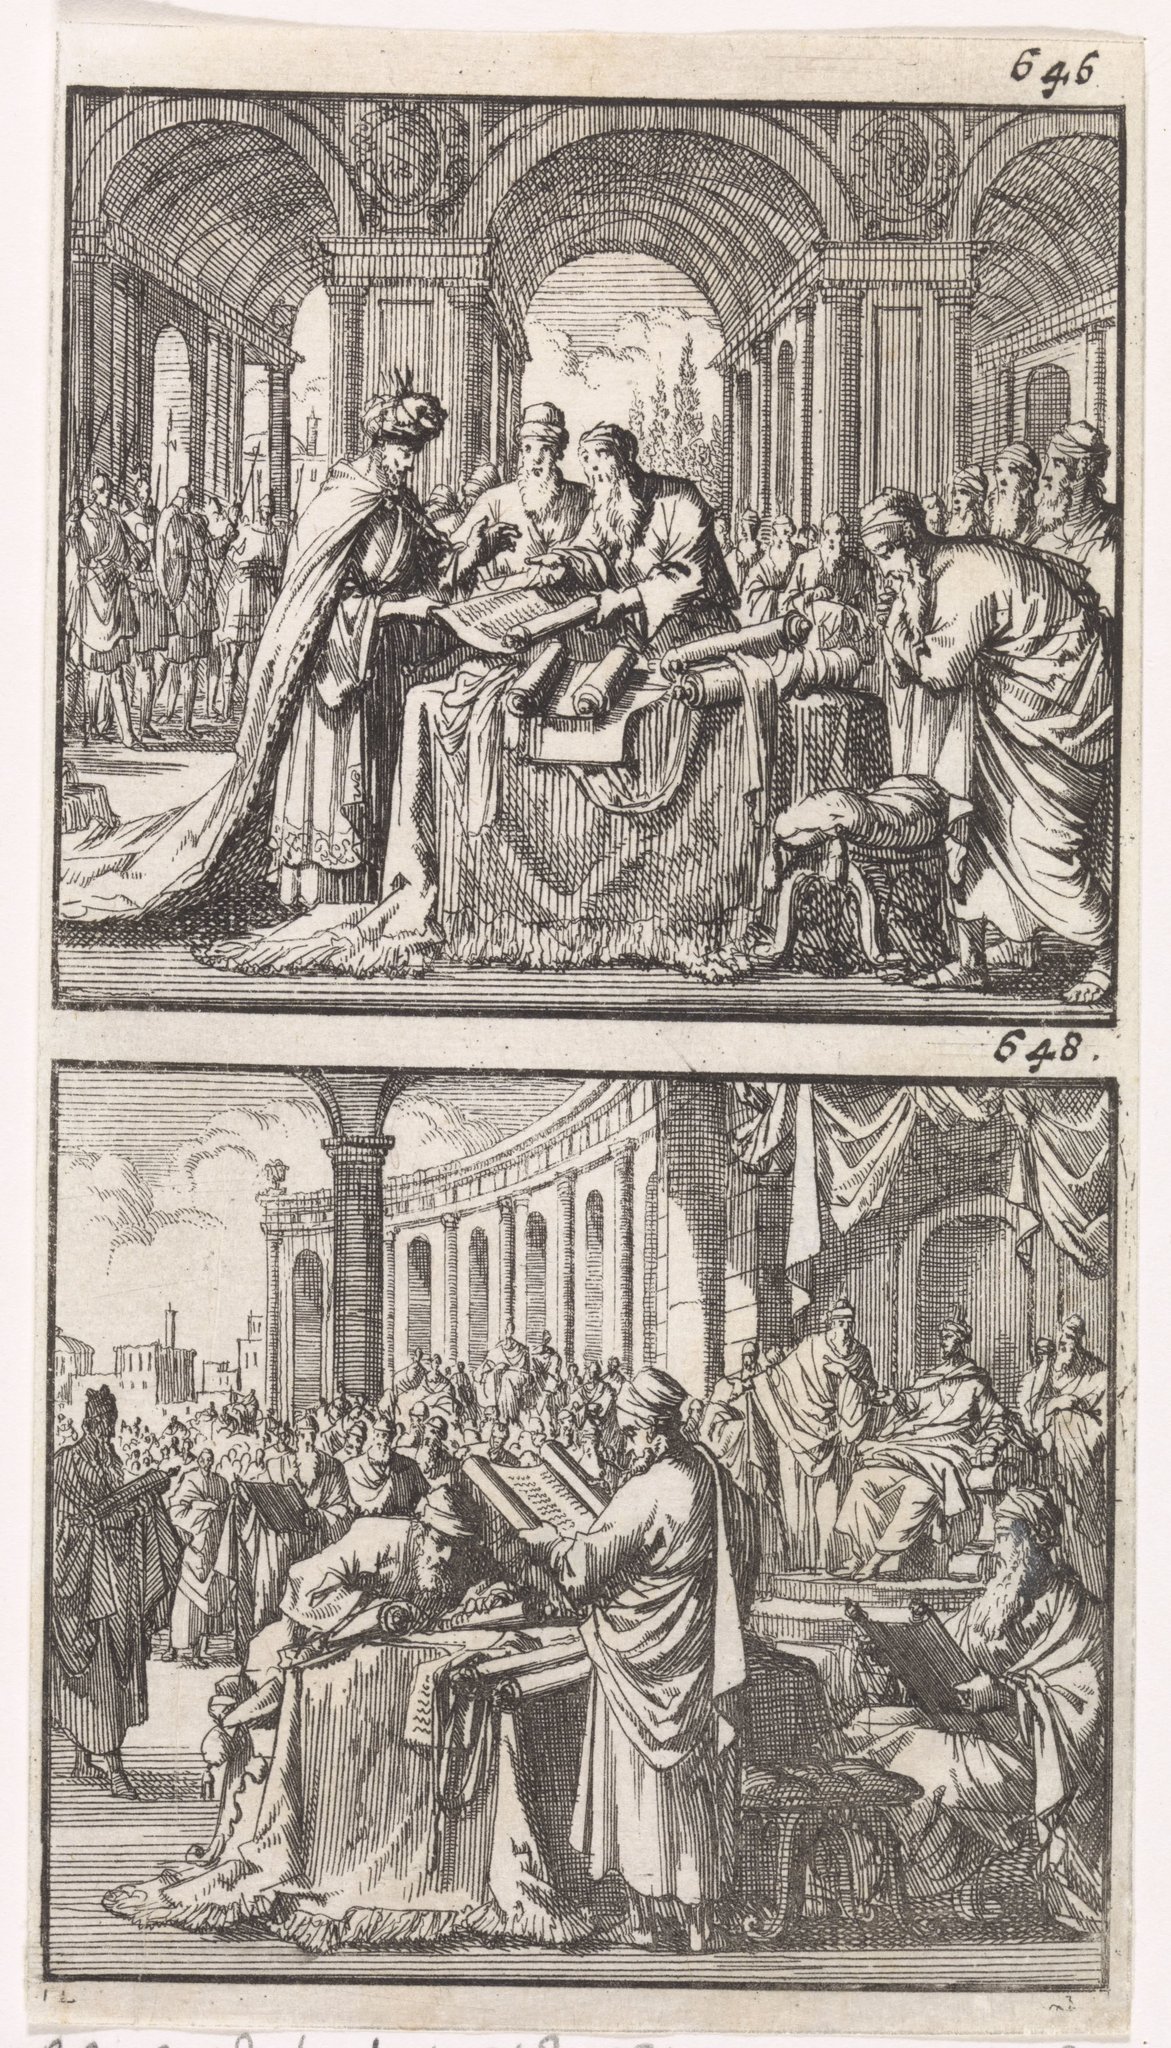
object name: print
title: Koning Ptolemaeus Philadelphus bestudeert de Hebreeuwse wetsrollen / Voorlezing van de vertaling der wet aan koning Ptolomaeus Philadelphus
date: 1698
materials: paper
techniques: etching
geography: amsterdam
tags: (story of) ptolemy philadelphus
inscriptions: collector's mark: Lugt 2228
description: Illustratie uit: Josephus, Flavius. XX. boeken van de oude geschiedenissen der joden, 4 delen. Amsterdam: Barent Visscher, Willem de Coup, Willem van Lamsveld, Andries van Damme, 1698, dl. II.